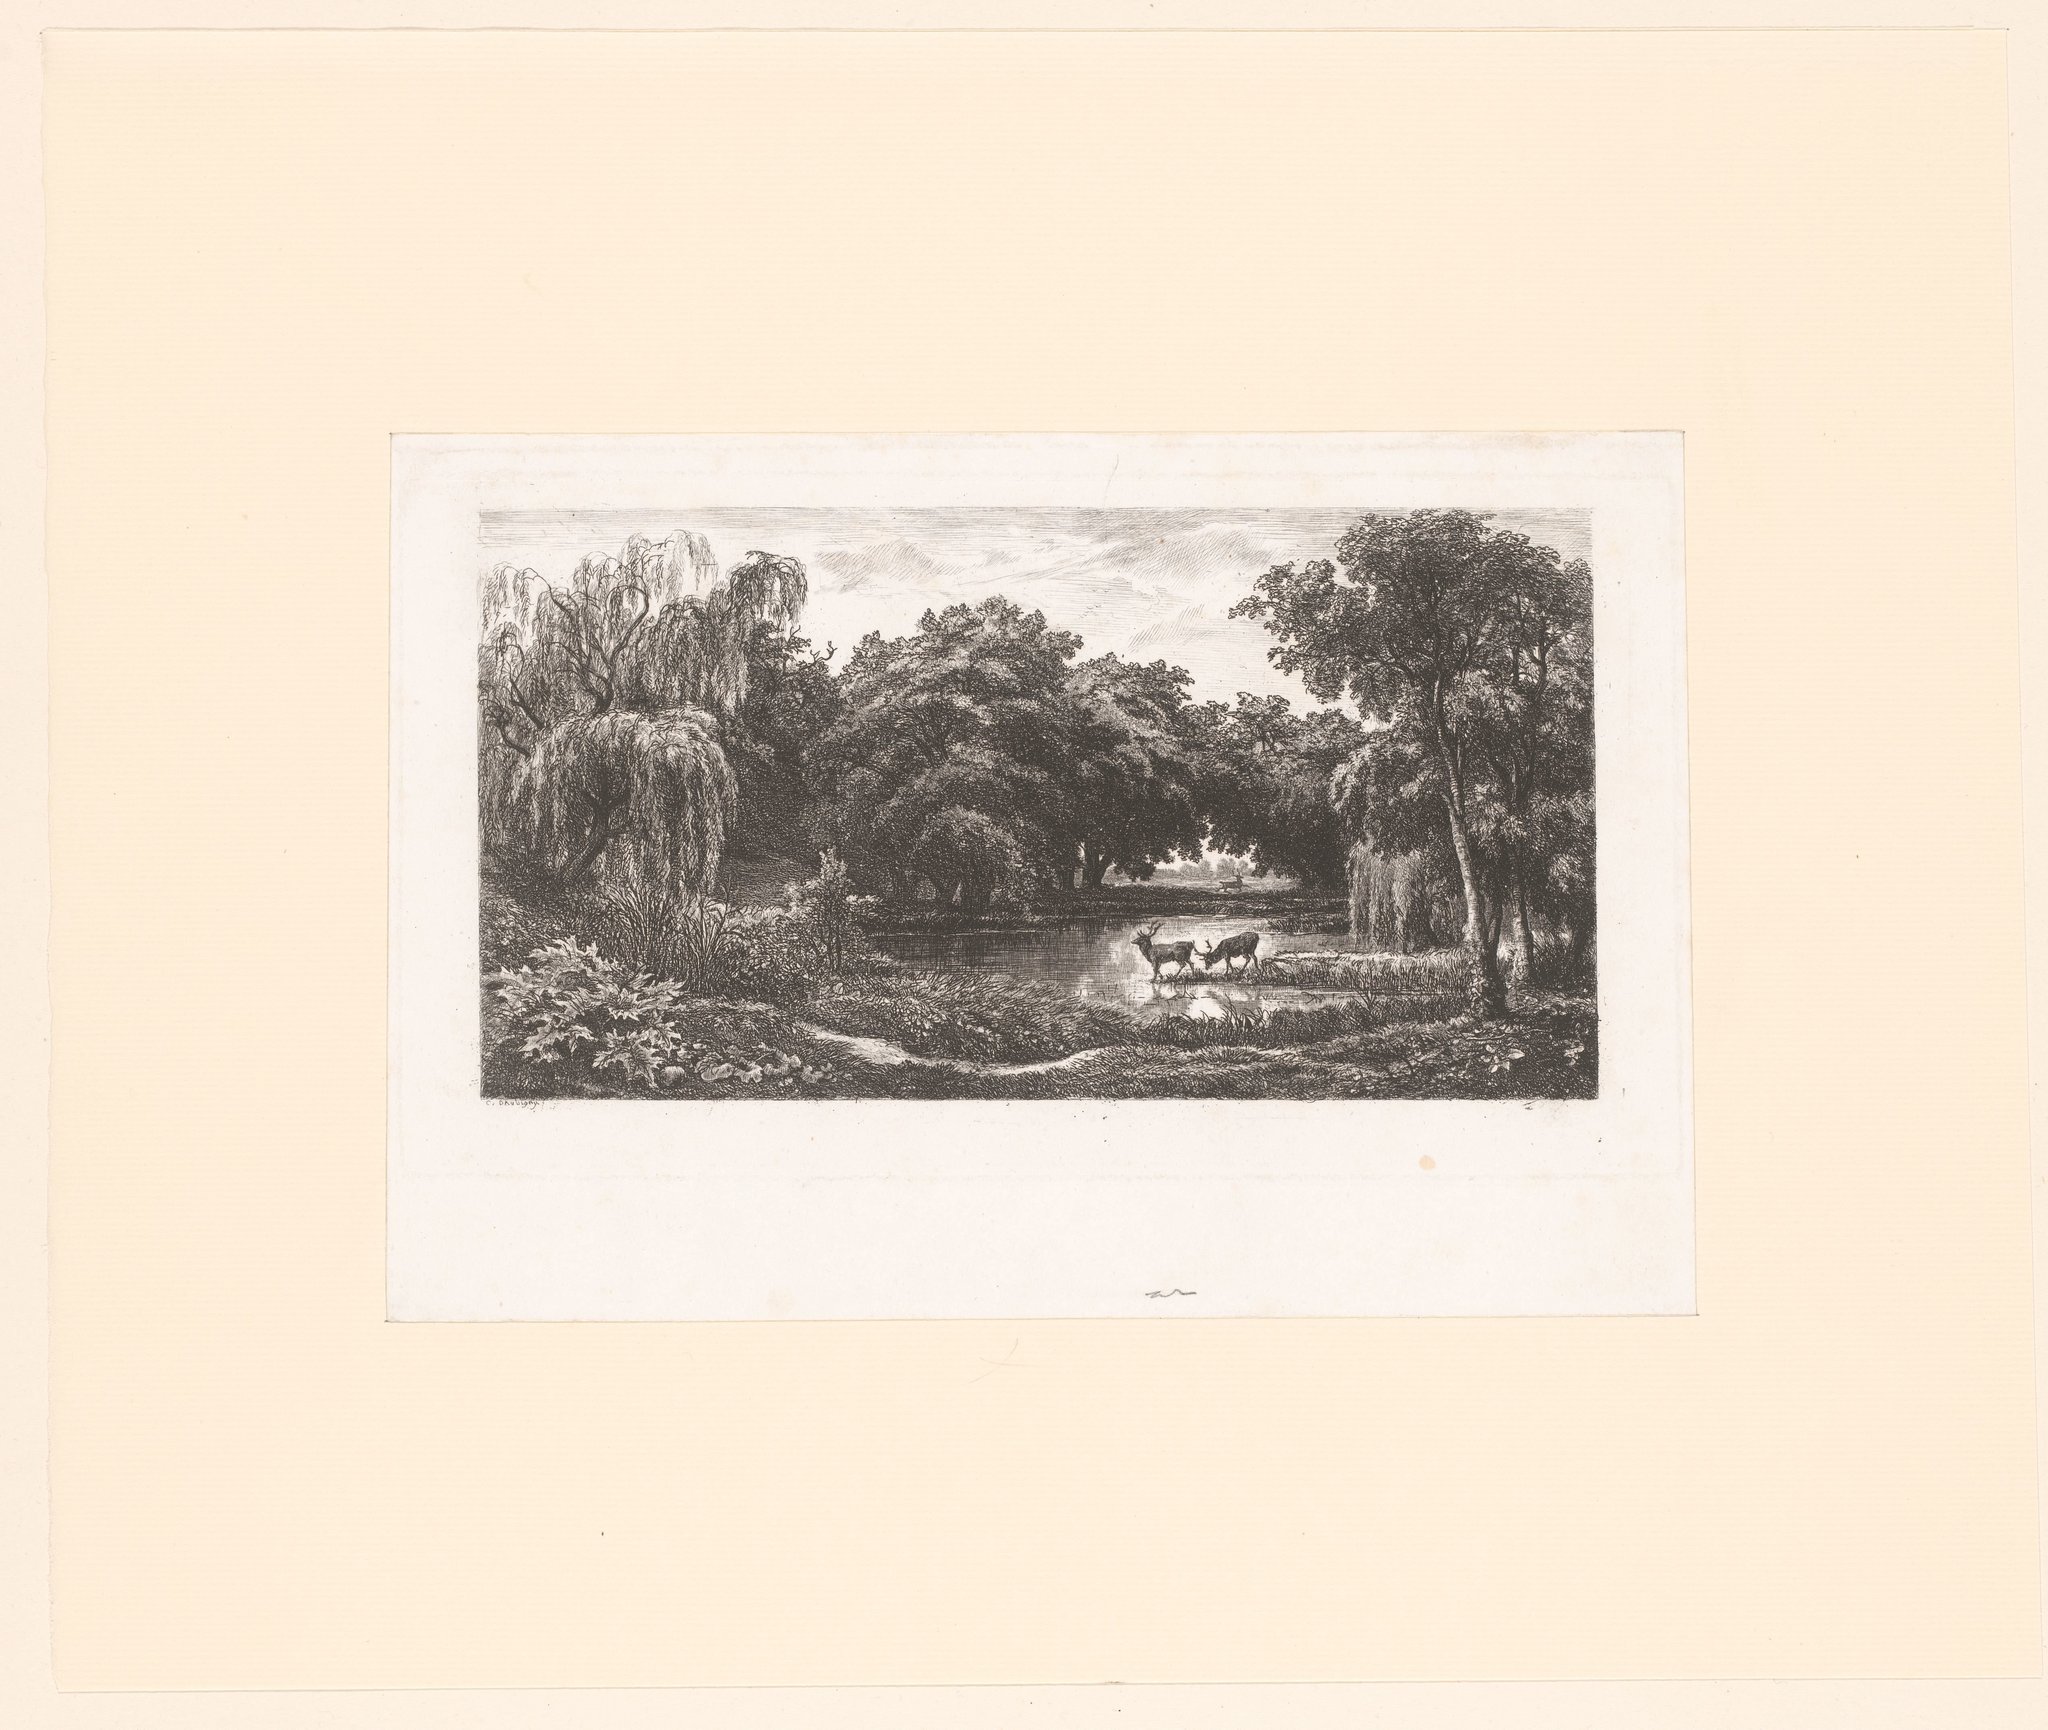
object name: print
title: Herten aan de rand van een vijver in het bos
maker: charles-françois daubigny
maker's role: draughtsman, painter, print maker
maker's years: 1817-1878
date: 1844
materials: paper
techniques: engraving, etching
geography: france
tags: hoofed animals: deer, forest, wood, pond, pool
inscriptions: collector's mark: Lugt 2760, collector's mark: Lugt 2228